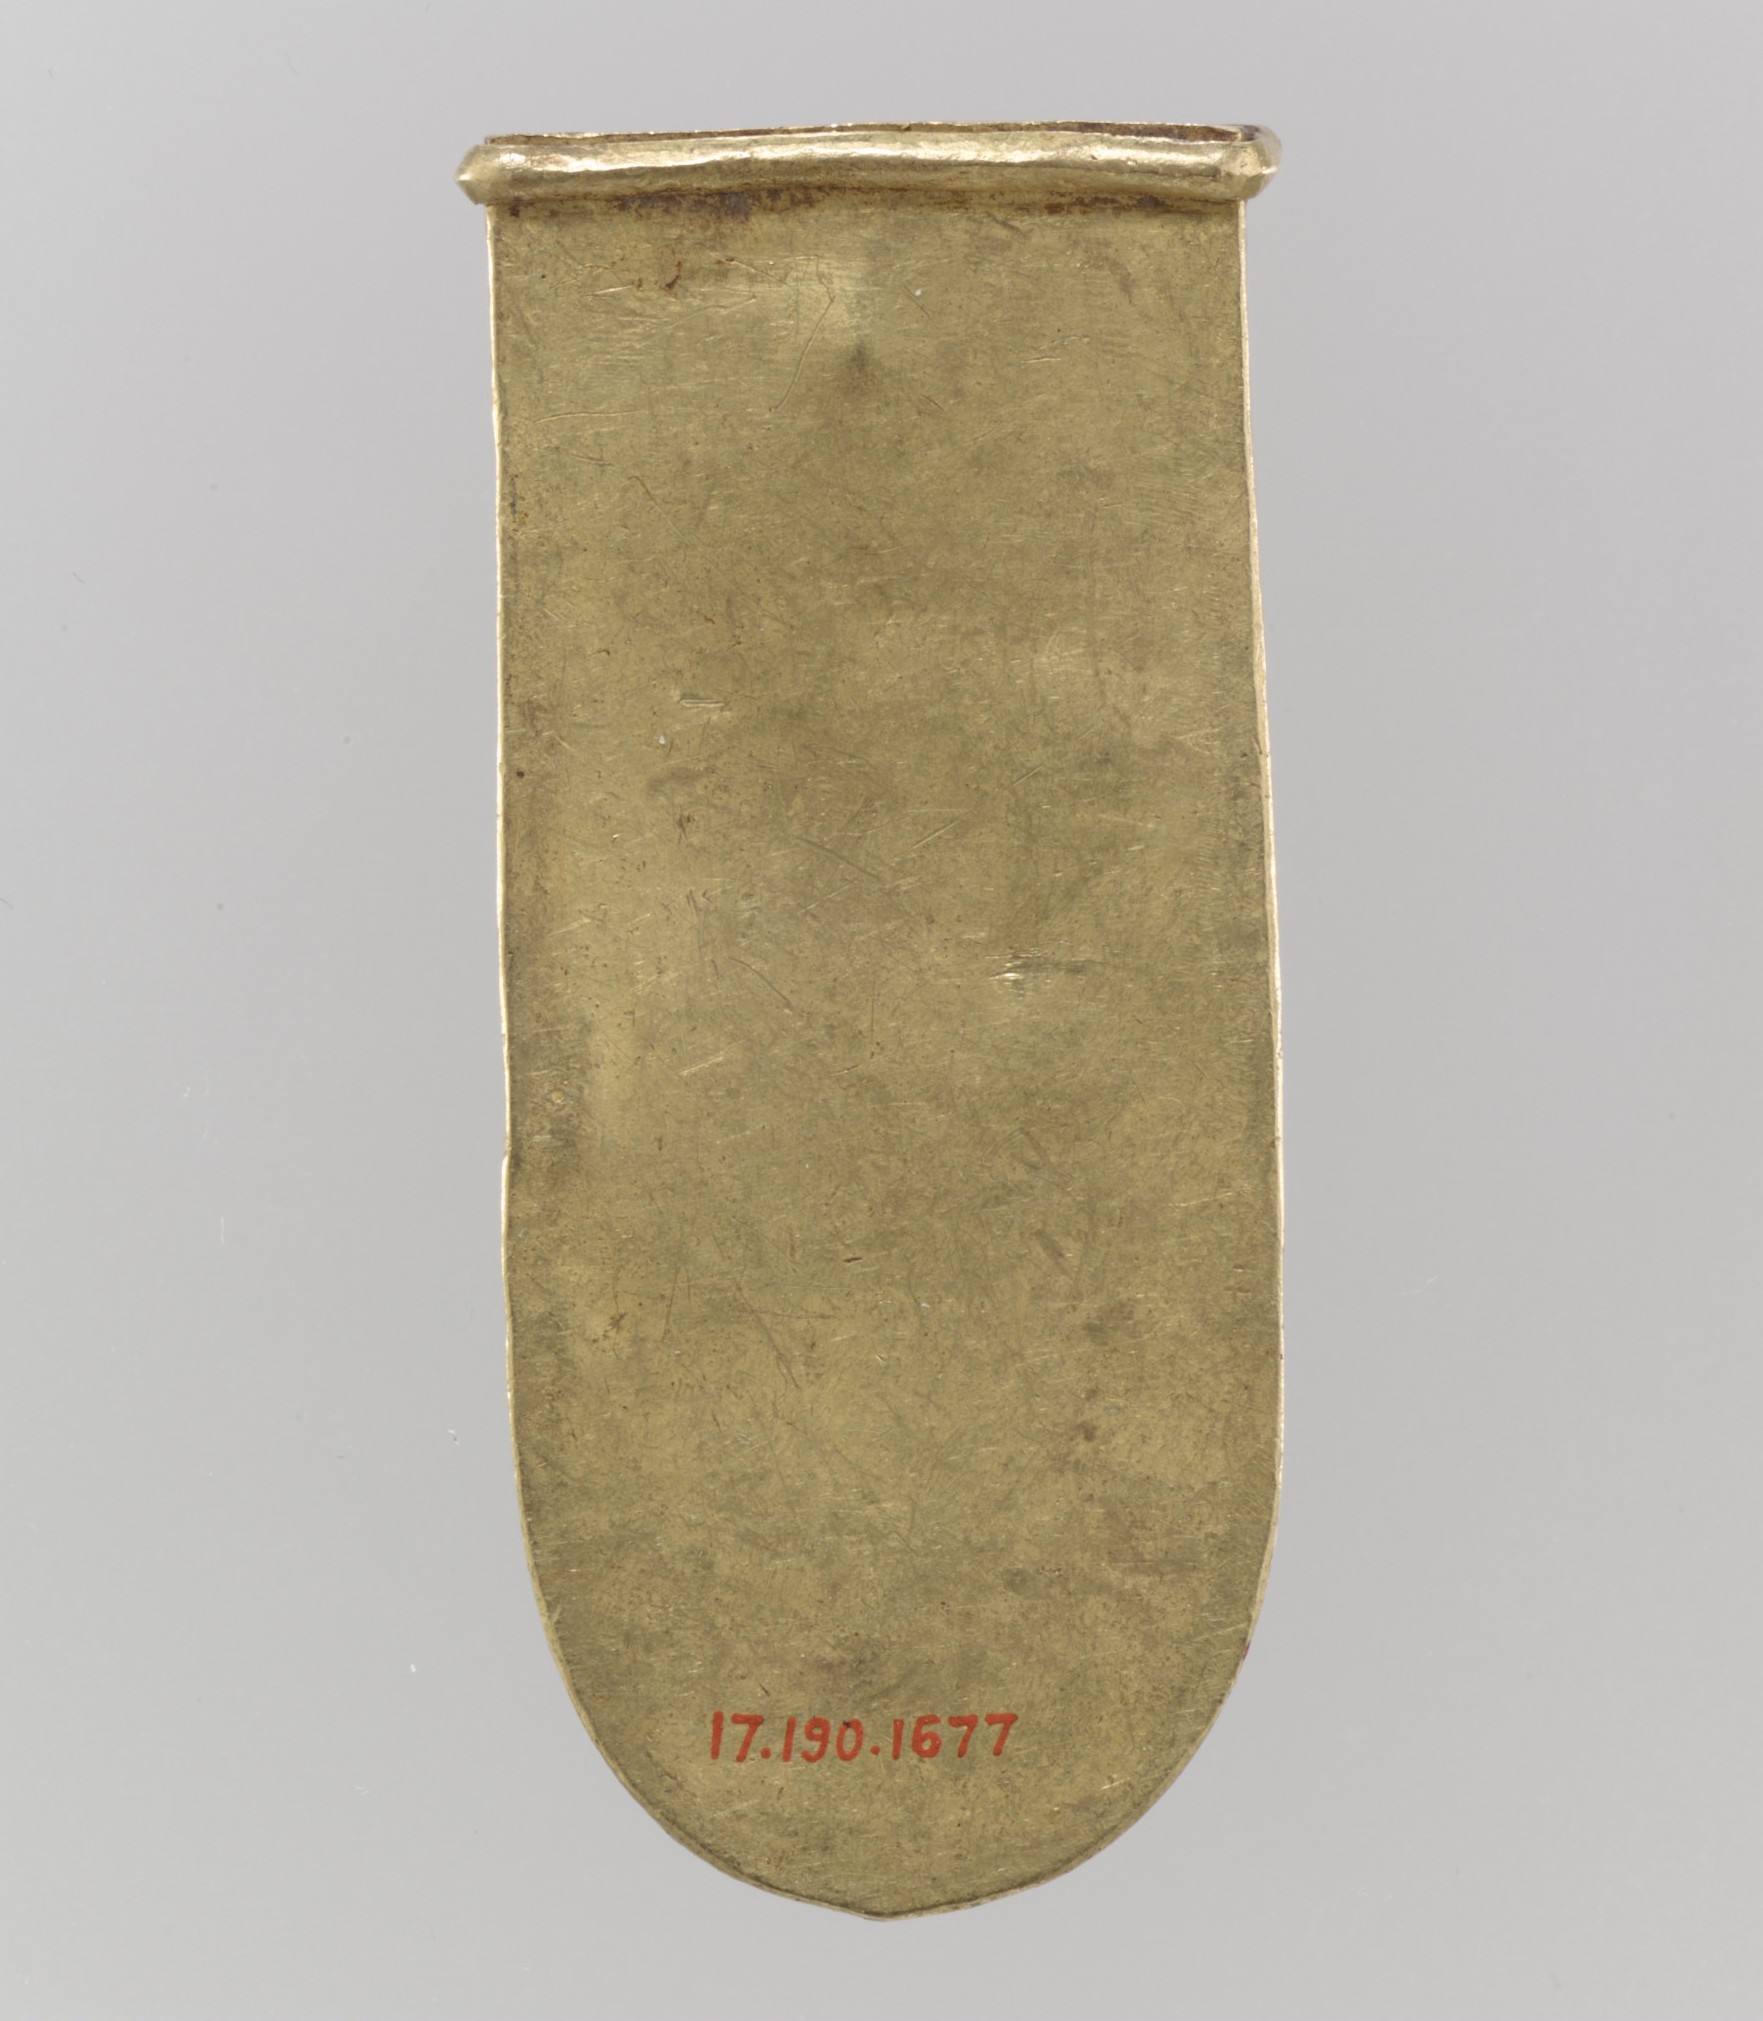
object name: belt strap end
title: Gold Strap End (Unfinished)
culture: avar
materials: gold